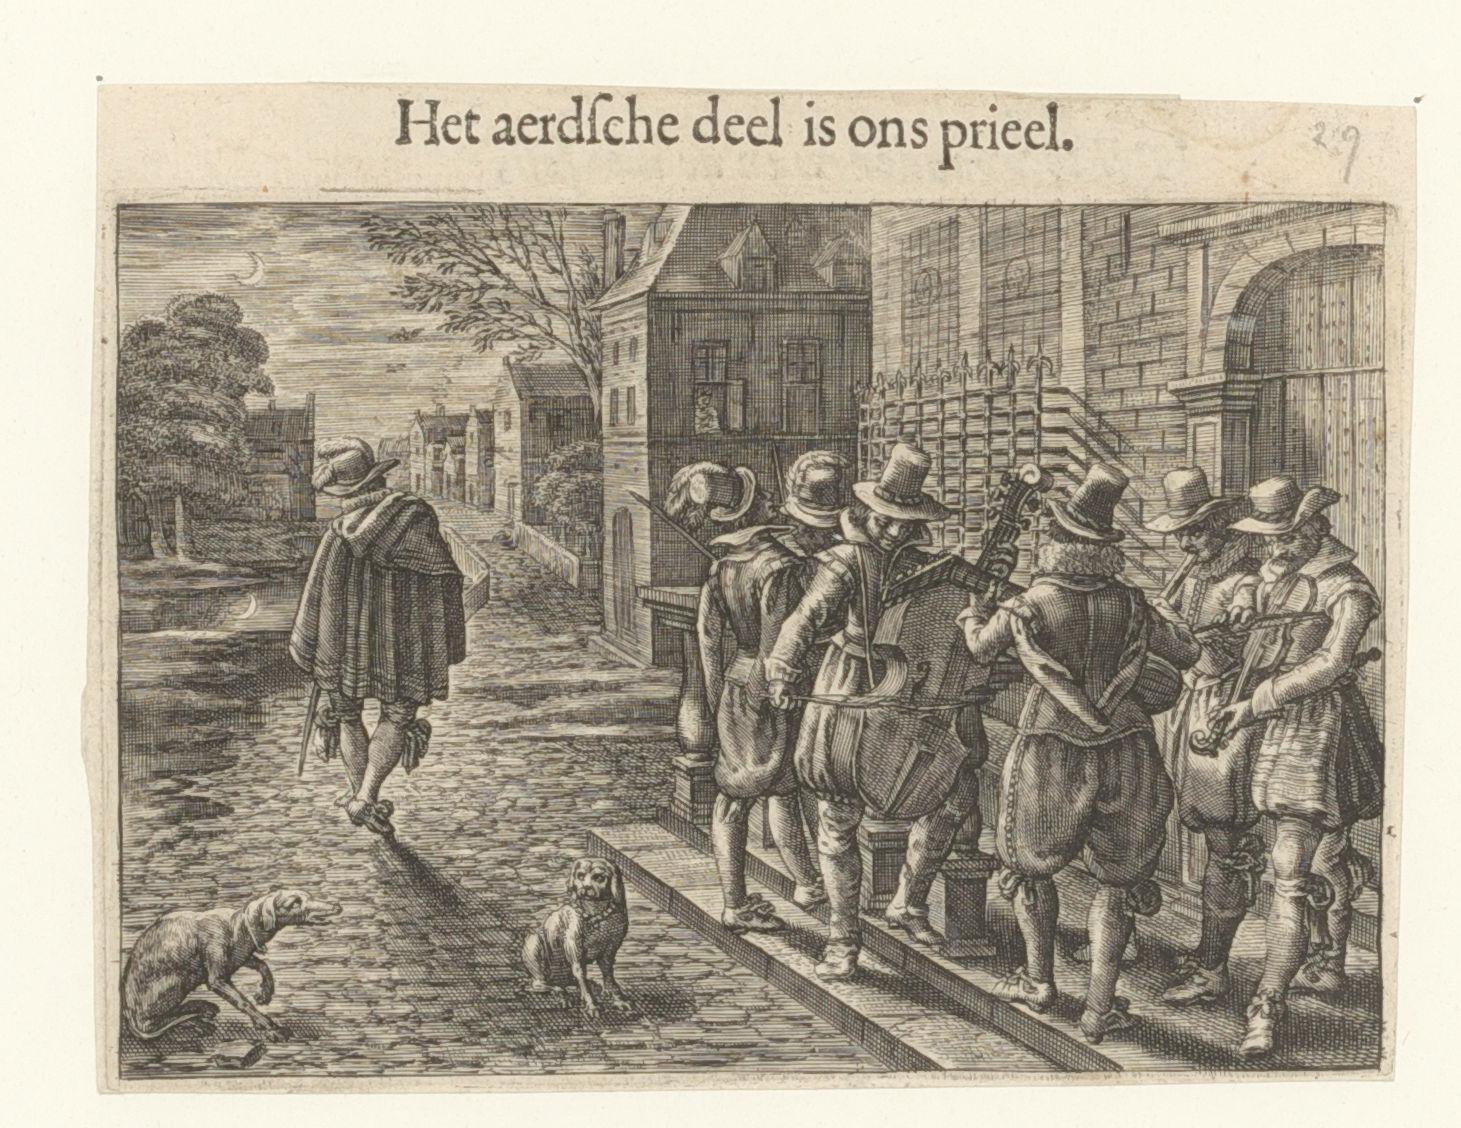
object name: book illustration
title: Groep muzikanten voor een gebouw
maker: Anonymous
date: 1624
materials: paper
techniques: engraving, letterpress printing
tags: the course of life symbolized, village street, proverbs, sayings, etc., adult man (+ back view), night, taking leave, dog, small group of musicians, chamber orchestra, jazz band - cc - 'concert champêtre'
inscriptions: stamp, collector's mark: Lugt 1641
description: Prent uit: Brune, Johan de. Zinne-werck, Voor-ghesyelt in Beelden, Ghedichten, ende breeder uyt-legginghen (...). Amsterdam: Evertsen Kloppenburch, 1624. Prent ook gebruikt in latere edities (1636 en 1661).